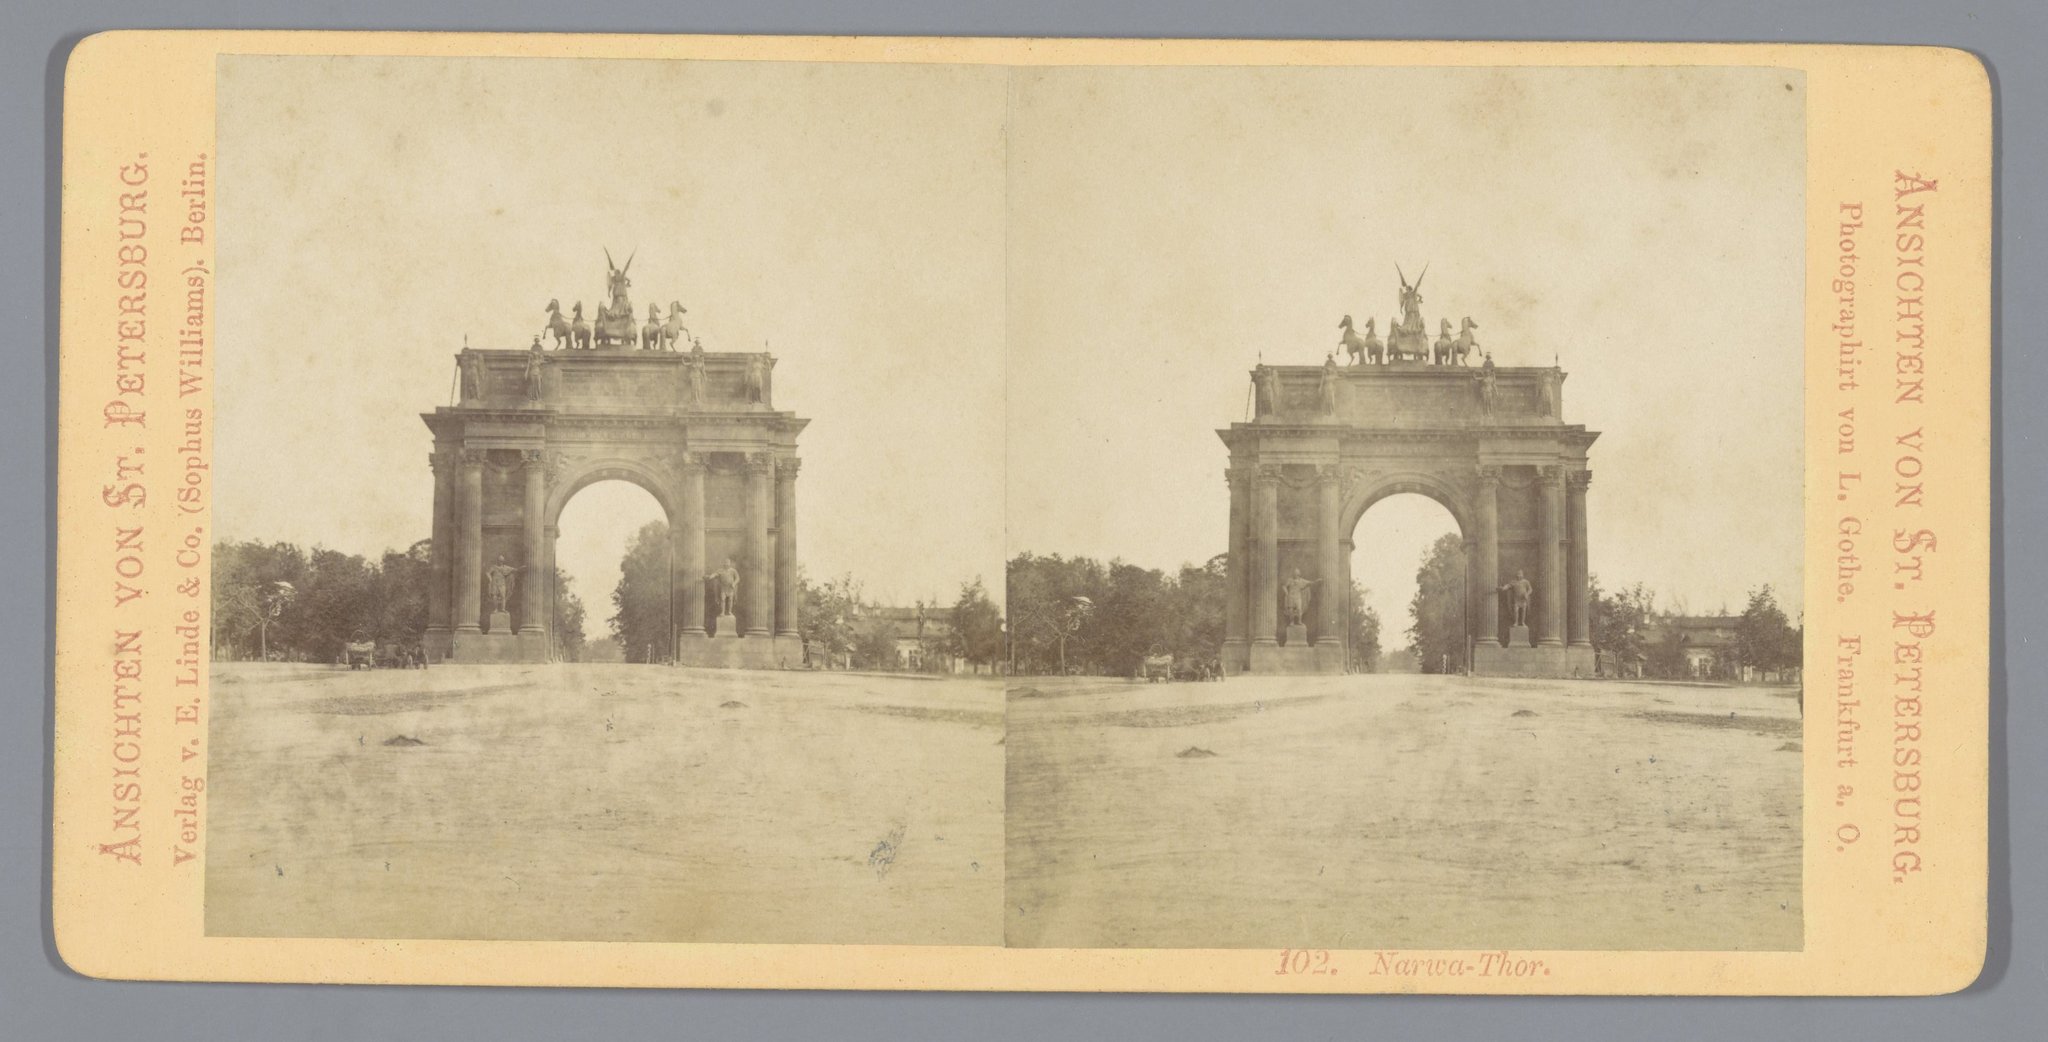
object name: stereograph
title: Narwa-Thor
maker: louis gothe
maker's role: fotograaf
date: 1850-1880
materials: cardboard, photographic support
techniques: albumen print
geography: berlin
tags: triumphal arch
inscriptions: inscription: ‘Ansichten von St. Petersburg.’, number: ‘102.’